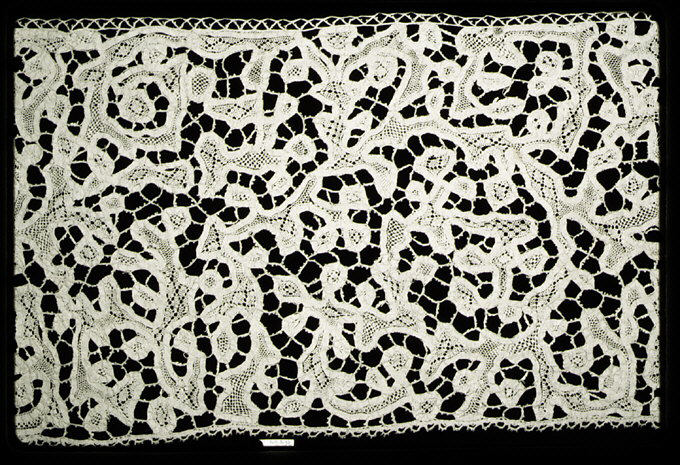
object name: border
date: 1701-1800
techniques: lace